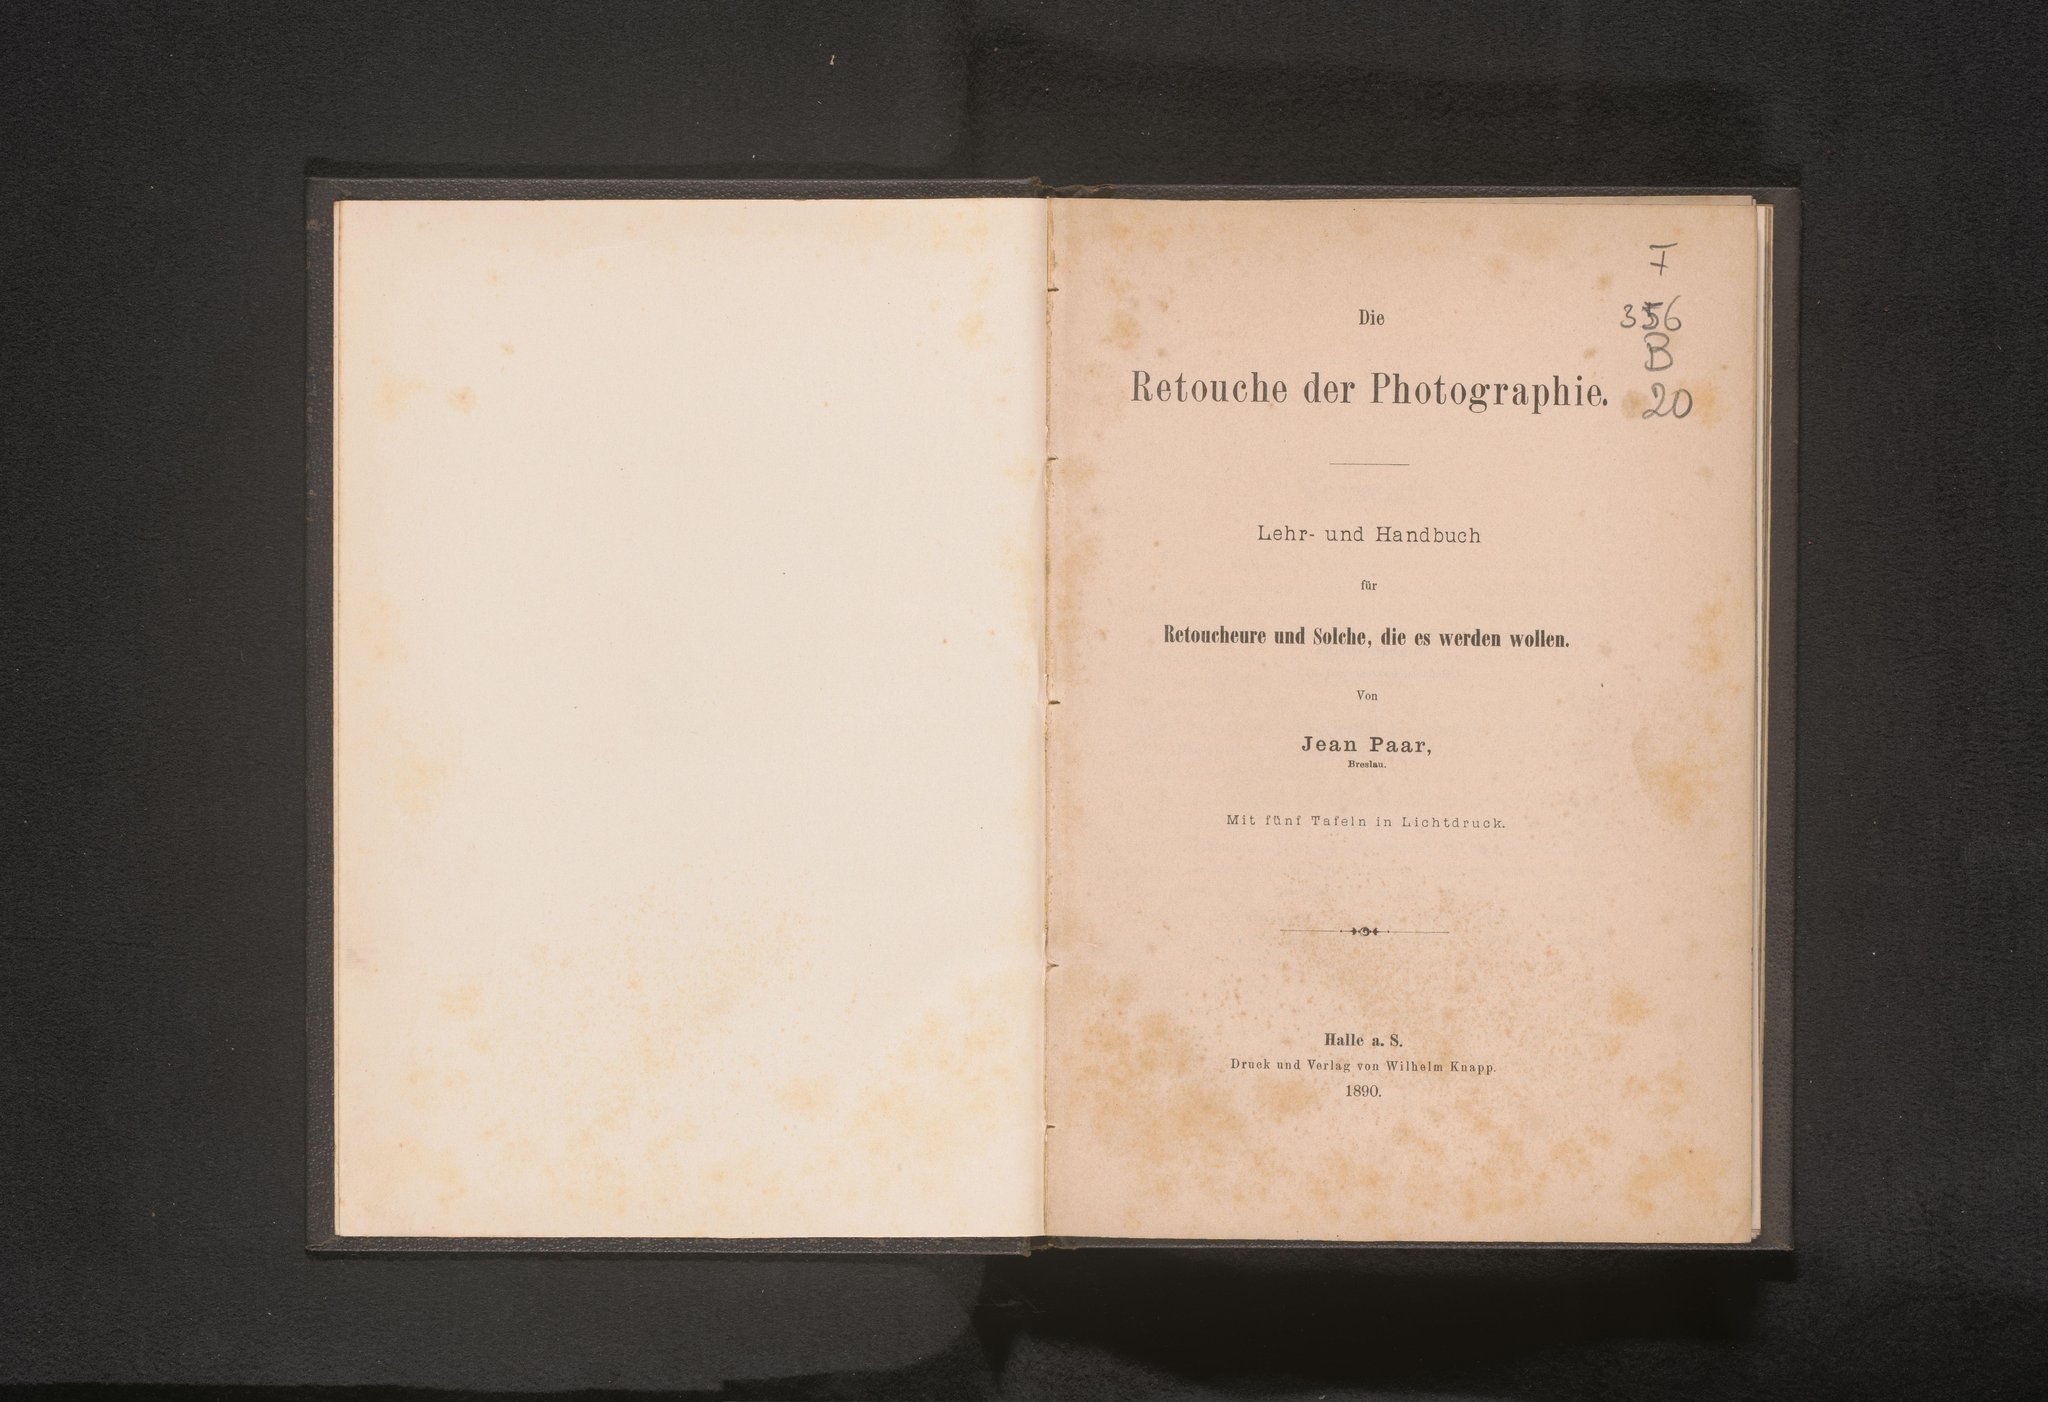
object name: book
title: Die Retouche der Photographie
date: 1890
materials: cardboard, linen, paper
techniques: photograph, printing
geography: halle an der saale